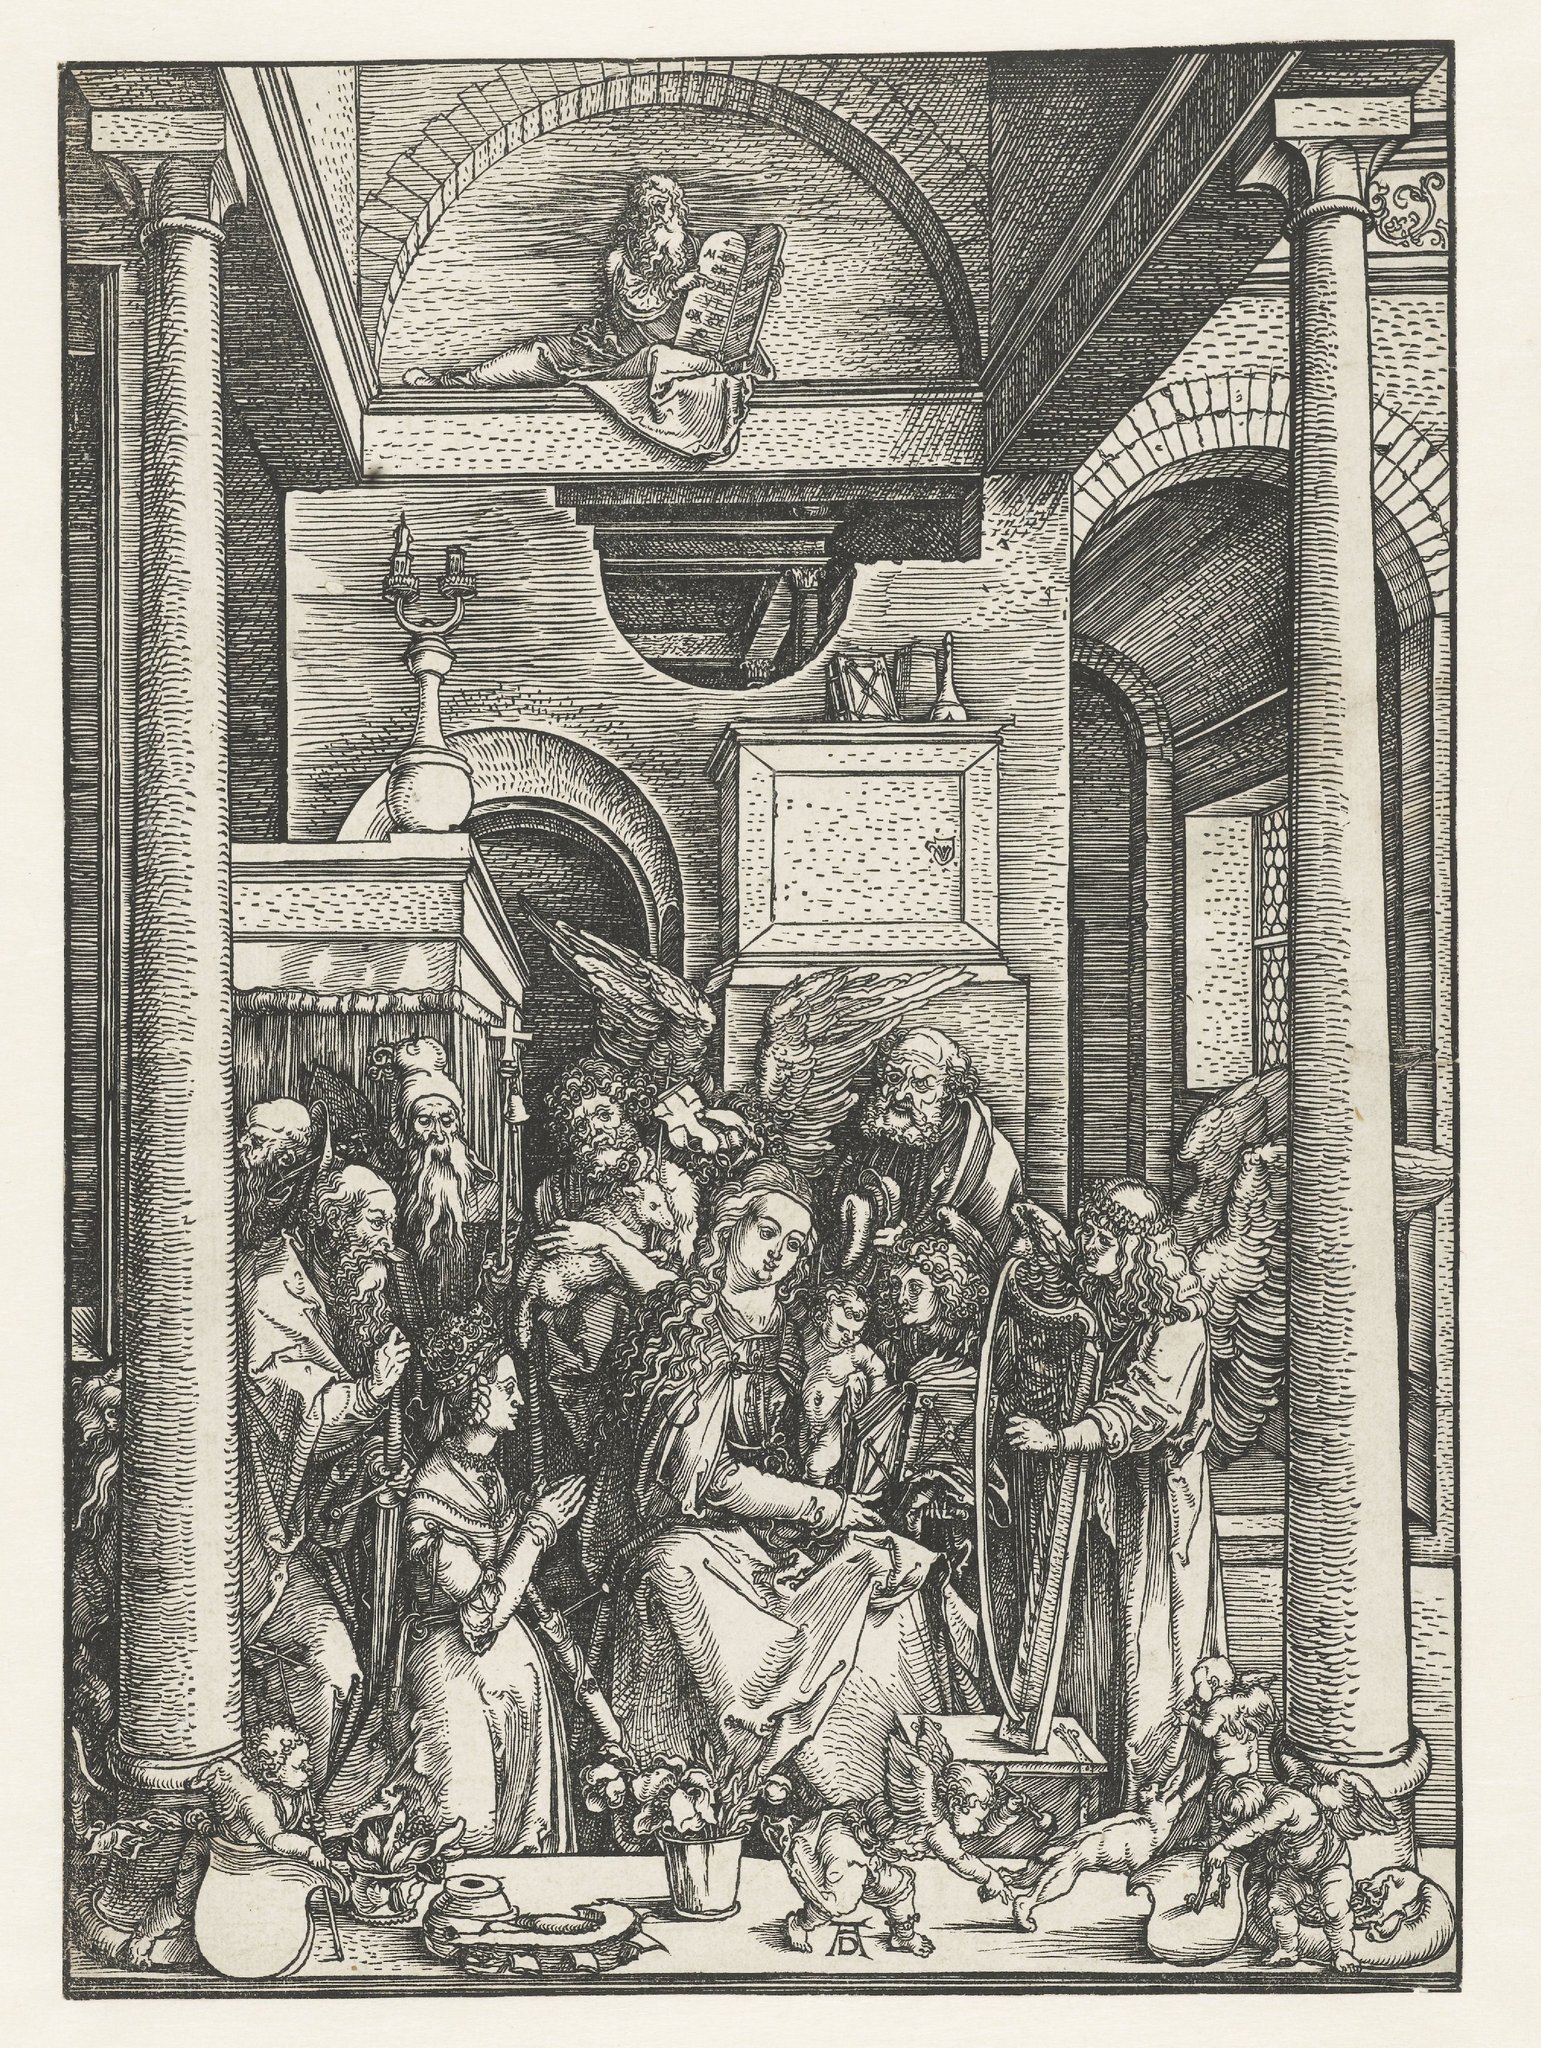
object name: print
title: Leven van Maria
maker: albrecht dürer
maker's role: draughtsman, painter, print maker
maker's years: 1471-1528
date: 1500-1504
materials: paper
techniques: woodcut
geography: nuremberg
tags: augustine, bishop of hippo; possible attributes: arrows piercing his breast, book, child with spoon, flaming heart, heart (pierced with arrows), pen, john the baptist; possible attributes: book, reed cross, baptismal cup, honeycomb, lamb, staff, madonna accompanied by saint(s), the foster-father of christ, joseph of nazareth, husband of mary; possible attributes: flowering rod or wand, lily, carpenter's tools, male saints (with name), the monk and hermit jerome (hieronymus); possible attributes: book, cardinal's hat, crucifix, hour-glass, lion, skull, stone, the hermit antony abbot (antonius abbas) of egypt, also called the great; possible attributes: bell, book, t-shaped staff, flames, pig, the apostle paul of tarsus; possible attributes: book, scroll, sword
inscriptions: collector's mark: Lugt 2228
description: Maria zit in een vertrek met het Christuskind op schoot, omringd door engelen en heiligen (Jozef, Catharina, Johannes de Doper, Hiëronymus, Antonius, Paulus en - hoewel niet helemaal zeker - Augustinus). Deze prent is onderdeel van een serie van 20 prenten, bestaand uit een titelprent en 19 prenten met scènes uit het leven van Maria.